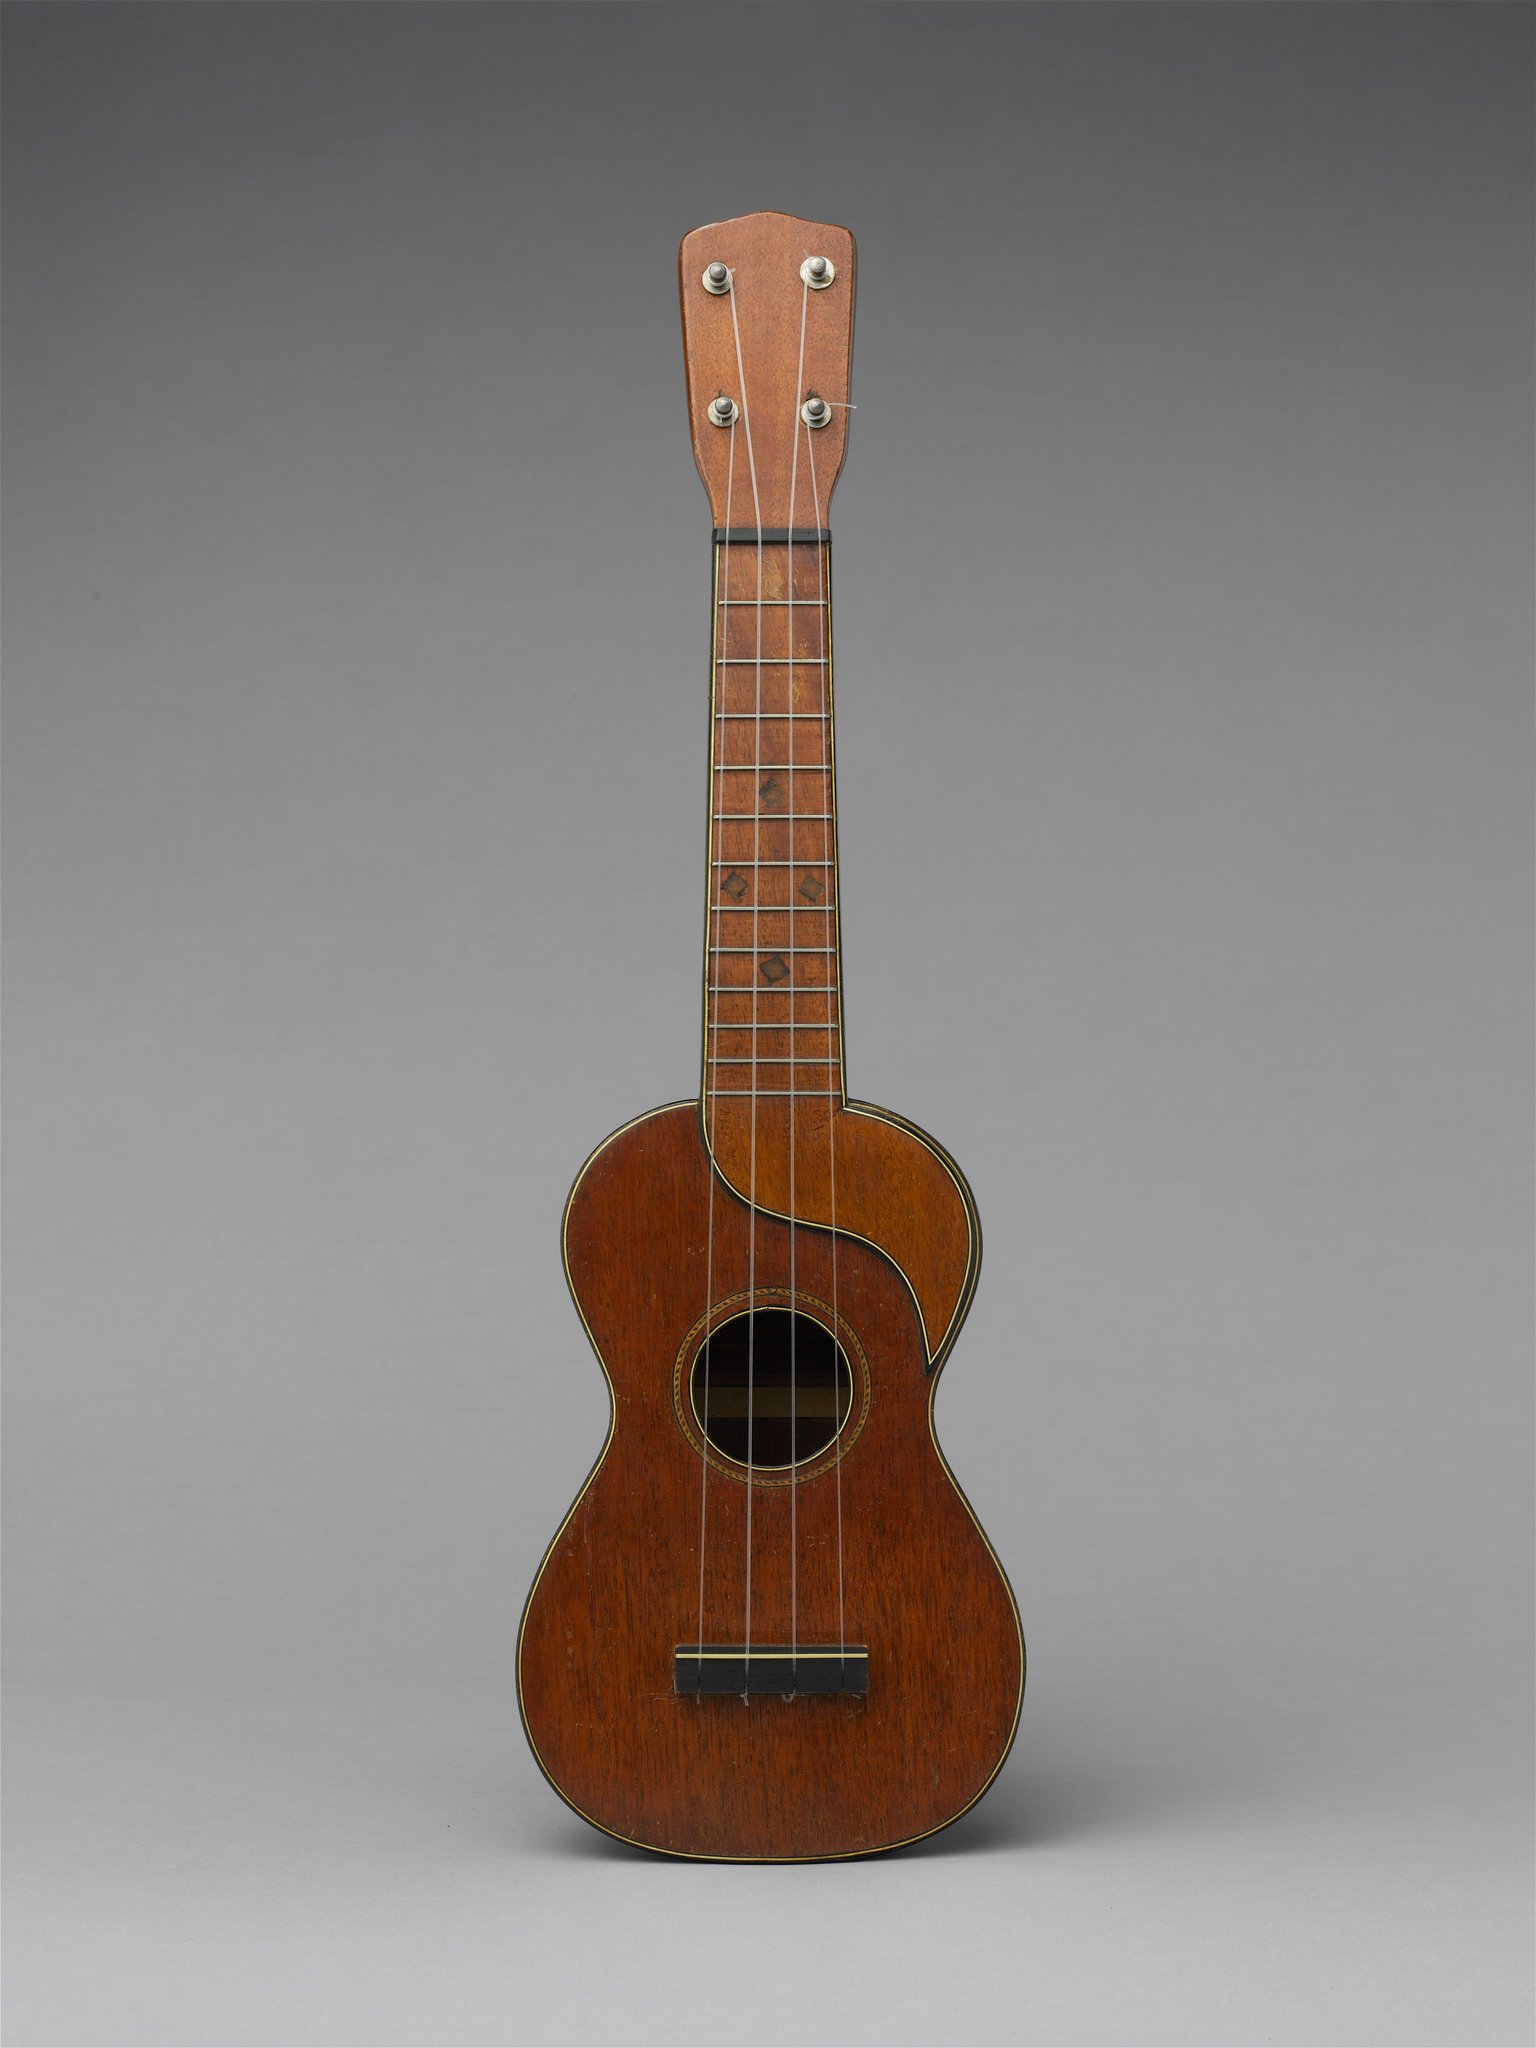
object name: ukulele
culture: american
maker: nicòla turturro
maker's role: maker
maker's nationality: american, born italy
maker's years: 1872-1953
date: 1928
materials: wood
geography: united states